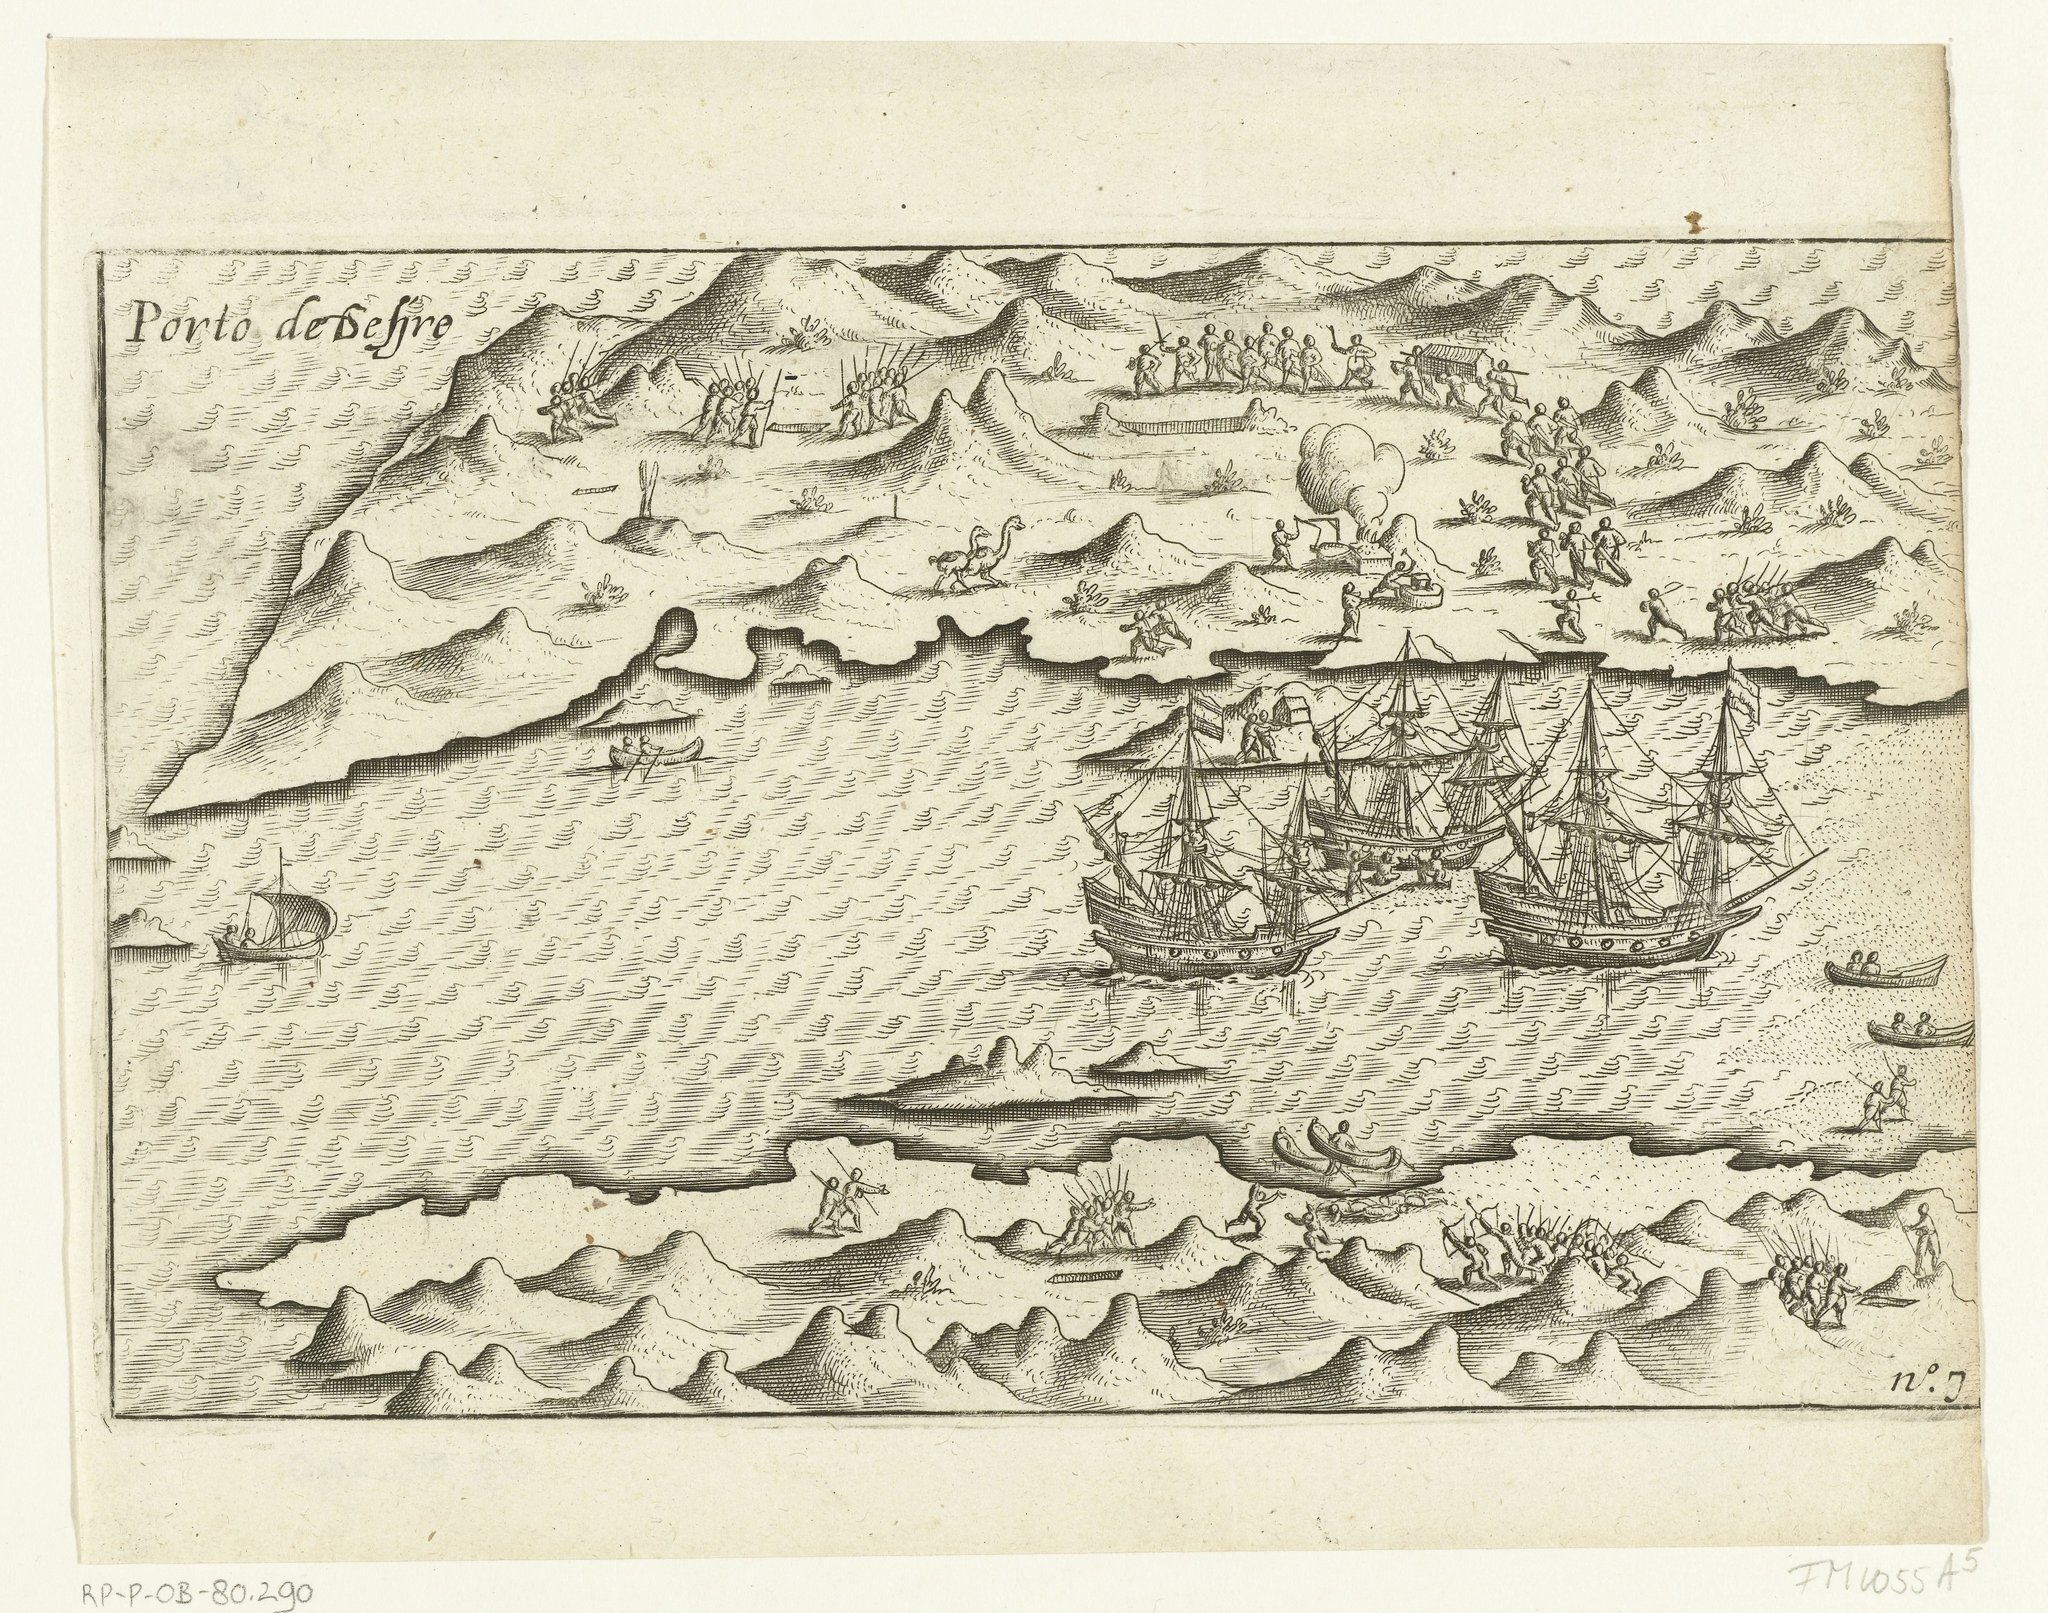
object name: print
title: Porto de Desire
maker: Anonymous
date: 1601-1602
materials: paper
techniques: engraving, etching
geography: northern netherlands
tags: utrecht, landscapes in tropical and sub-tropical regions, exploration, expedition, voyage of discovery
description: Gebruikt als illustratie eerst in: O. van Noort, Beschryvinghe vande voyagie om den geheelen werelt cloot, ghedaen door Olivier van Noort van Utrecht. ... door de Strate Magellanes, ... langs de custen van Cica, Chili ende Peru, om den gantschen aerden cloot, ende door de Molucques wederom thuys te comen. : Te zeyl gegaen van Rotterdam ... 1598. Ende ... weder ghekeert ... 1601. Daer in dat vertelt wort zyne wonderlijcke avontueren, Jan van Waesberge (II) te Rotterdam en Cornelis Claes te Amsterdam 1602. Later gebruikt in: Oost-Indische ende West-Indische voyagien, Michiel Colijn, Amsterdam 1619 en in deze staat eerst gebruikt in: Beschrijvinge van de Schipvaerd by de Hollanders ghedaen onder 't beleydt ende Generaelschap van Olivier van Noort, door de Straet of Engte van Magallanes, ende voorts de gantsche kloot des Aertbodems om. Opgenomen in: I. Commelin, Begin ende voortgangh, van de Vereenighde Nederlantsche Geoctroyeerde Oost-Indische Compagnie, J. Janssonius, Amsterdam 1646. Genummerd: 7.